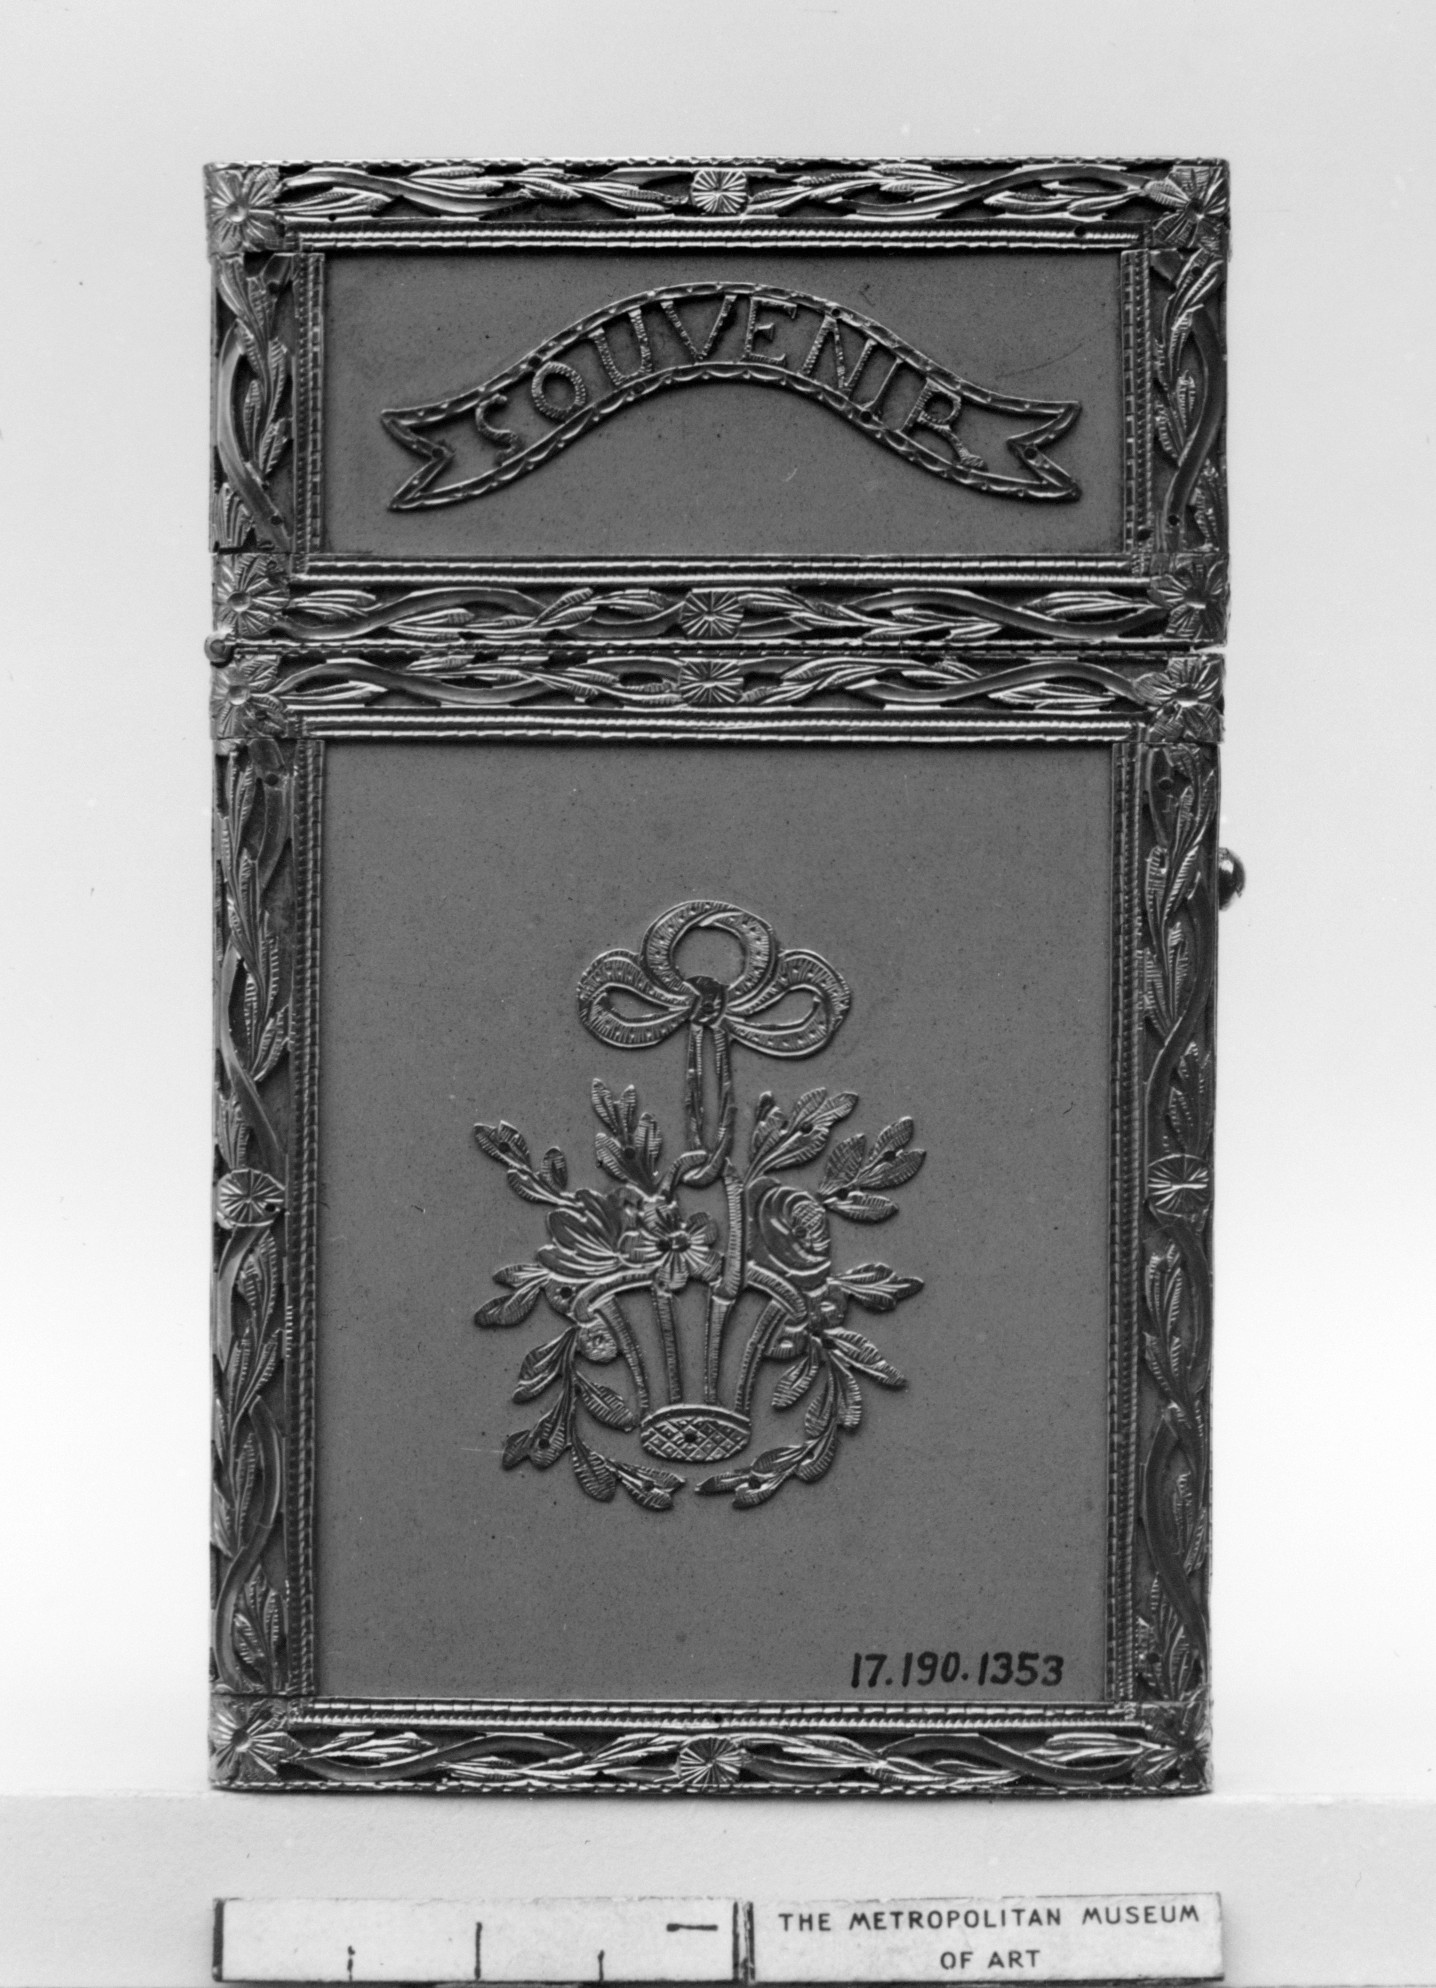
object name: souvenir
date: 1768-1769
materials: gold, ivory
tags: flowers